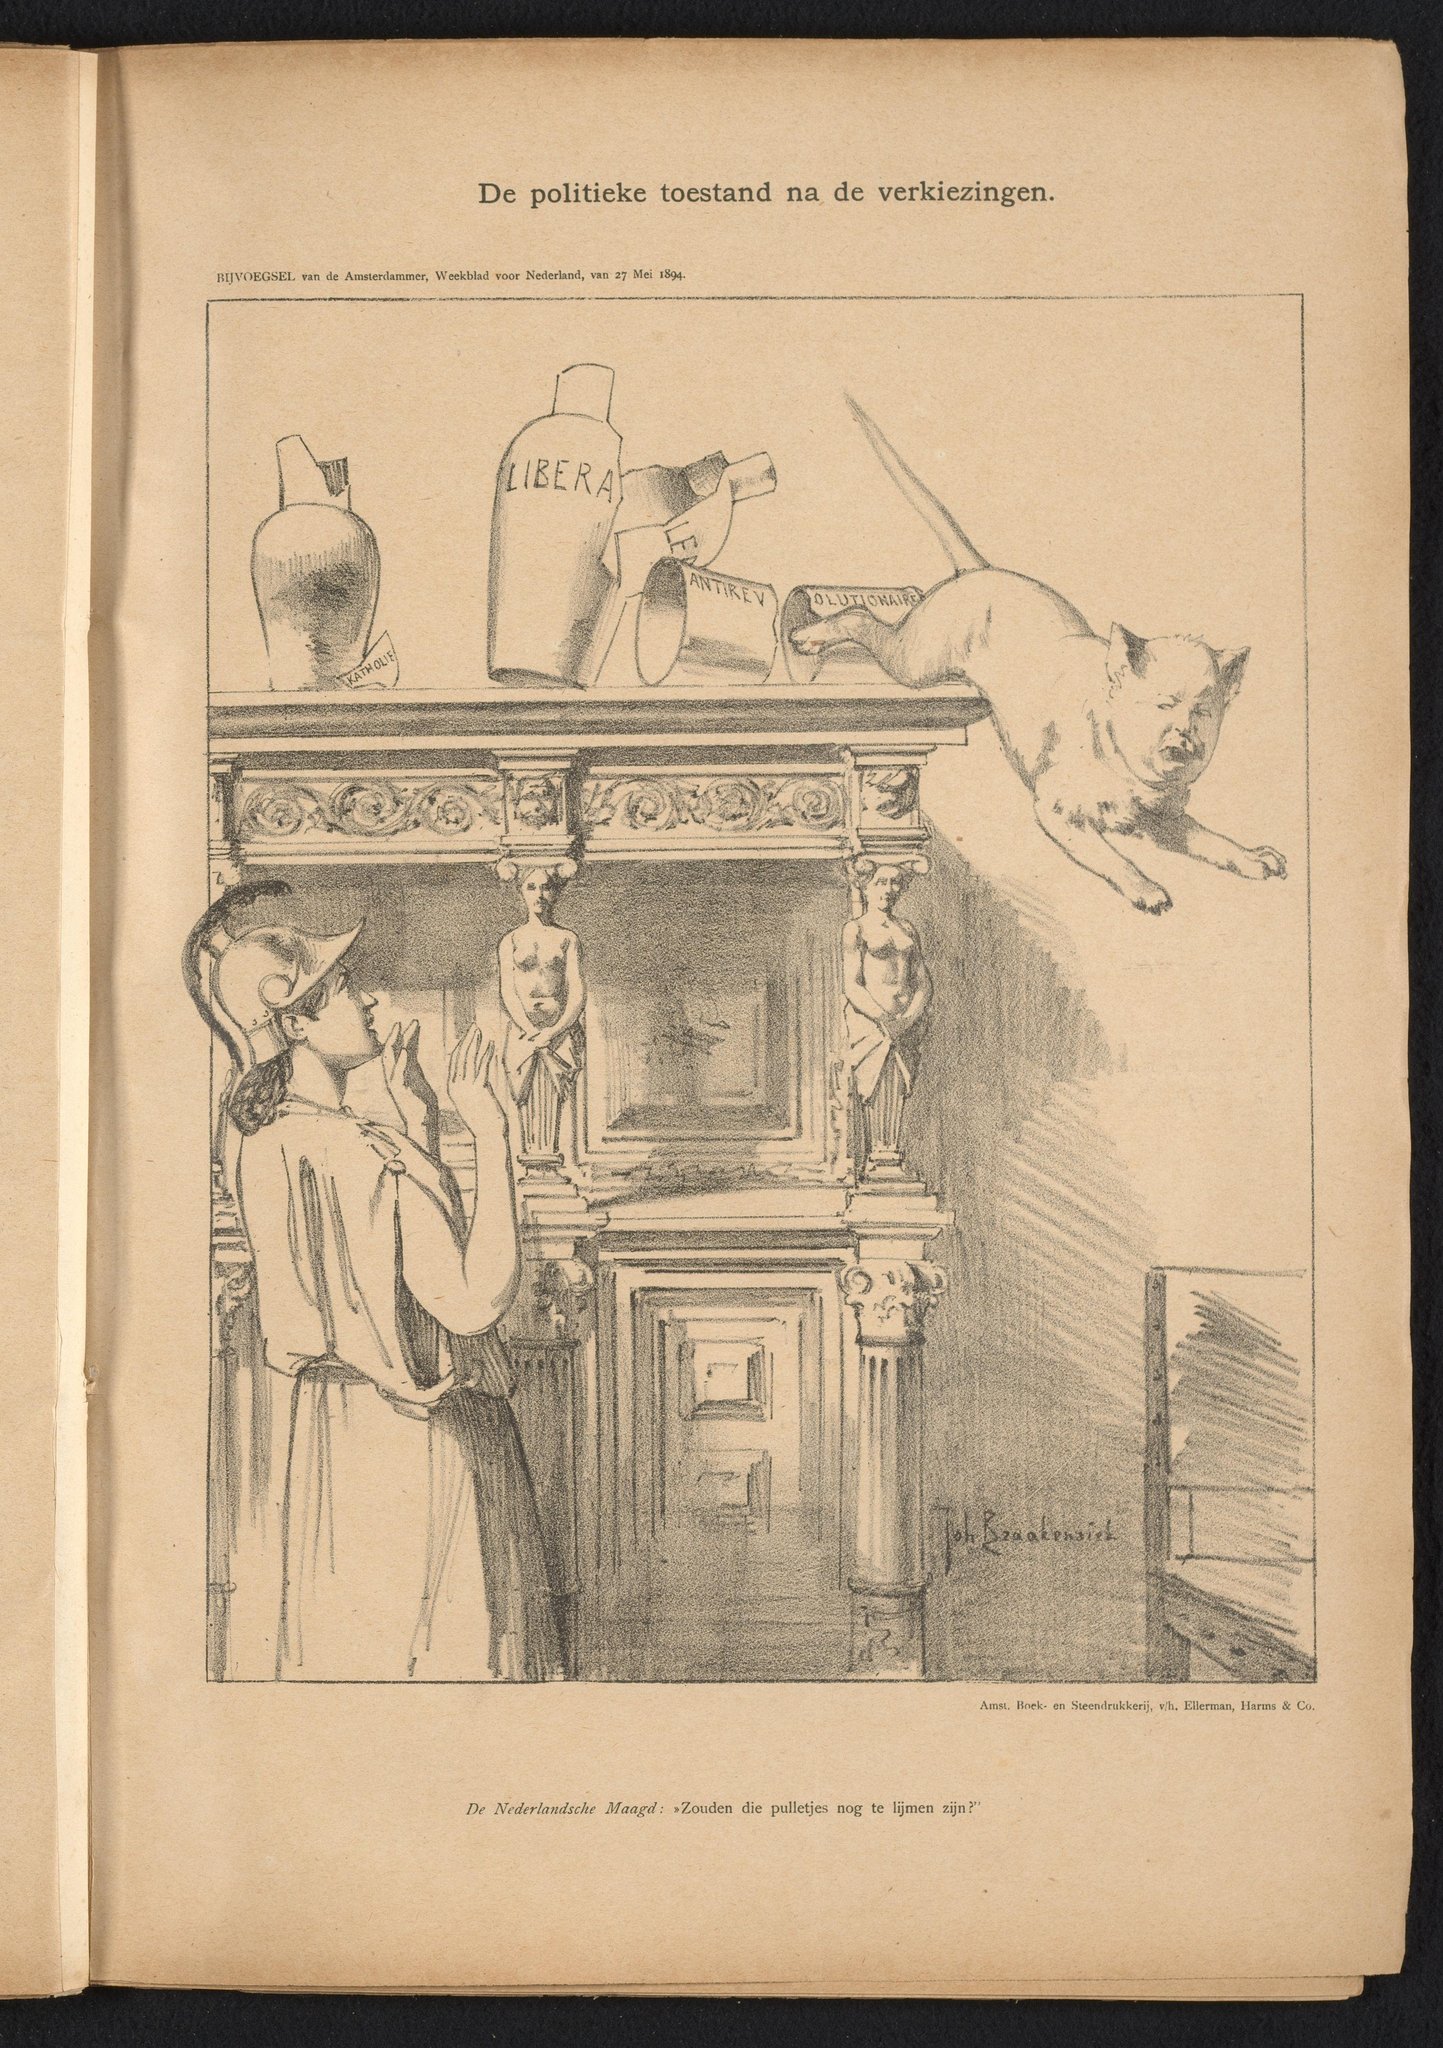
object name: cartoon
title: De politieke toestand na de verkiezingen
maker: johan braakensiek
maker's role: draughtsman, print maker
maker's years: 1858-1940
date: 1894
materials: paper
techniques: lithograph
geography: amsterdam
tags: the hague, personifications of countries, nations, states, districts, etc., cat, political caricatures and satires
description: De Nederlandse Maagd ziet verschrikt hoe een wegspringende kat, Tak van Poortvliet, de vazen van een kaststel, de politieke partijen, breekt.